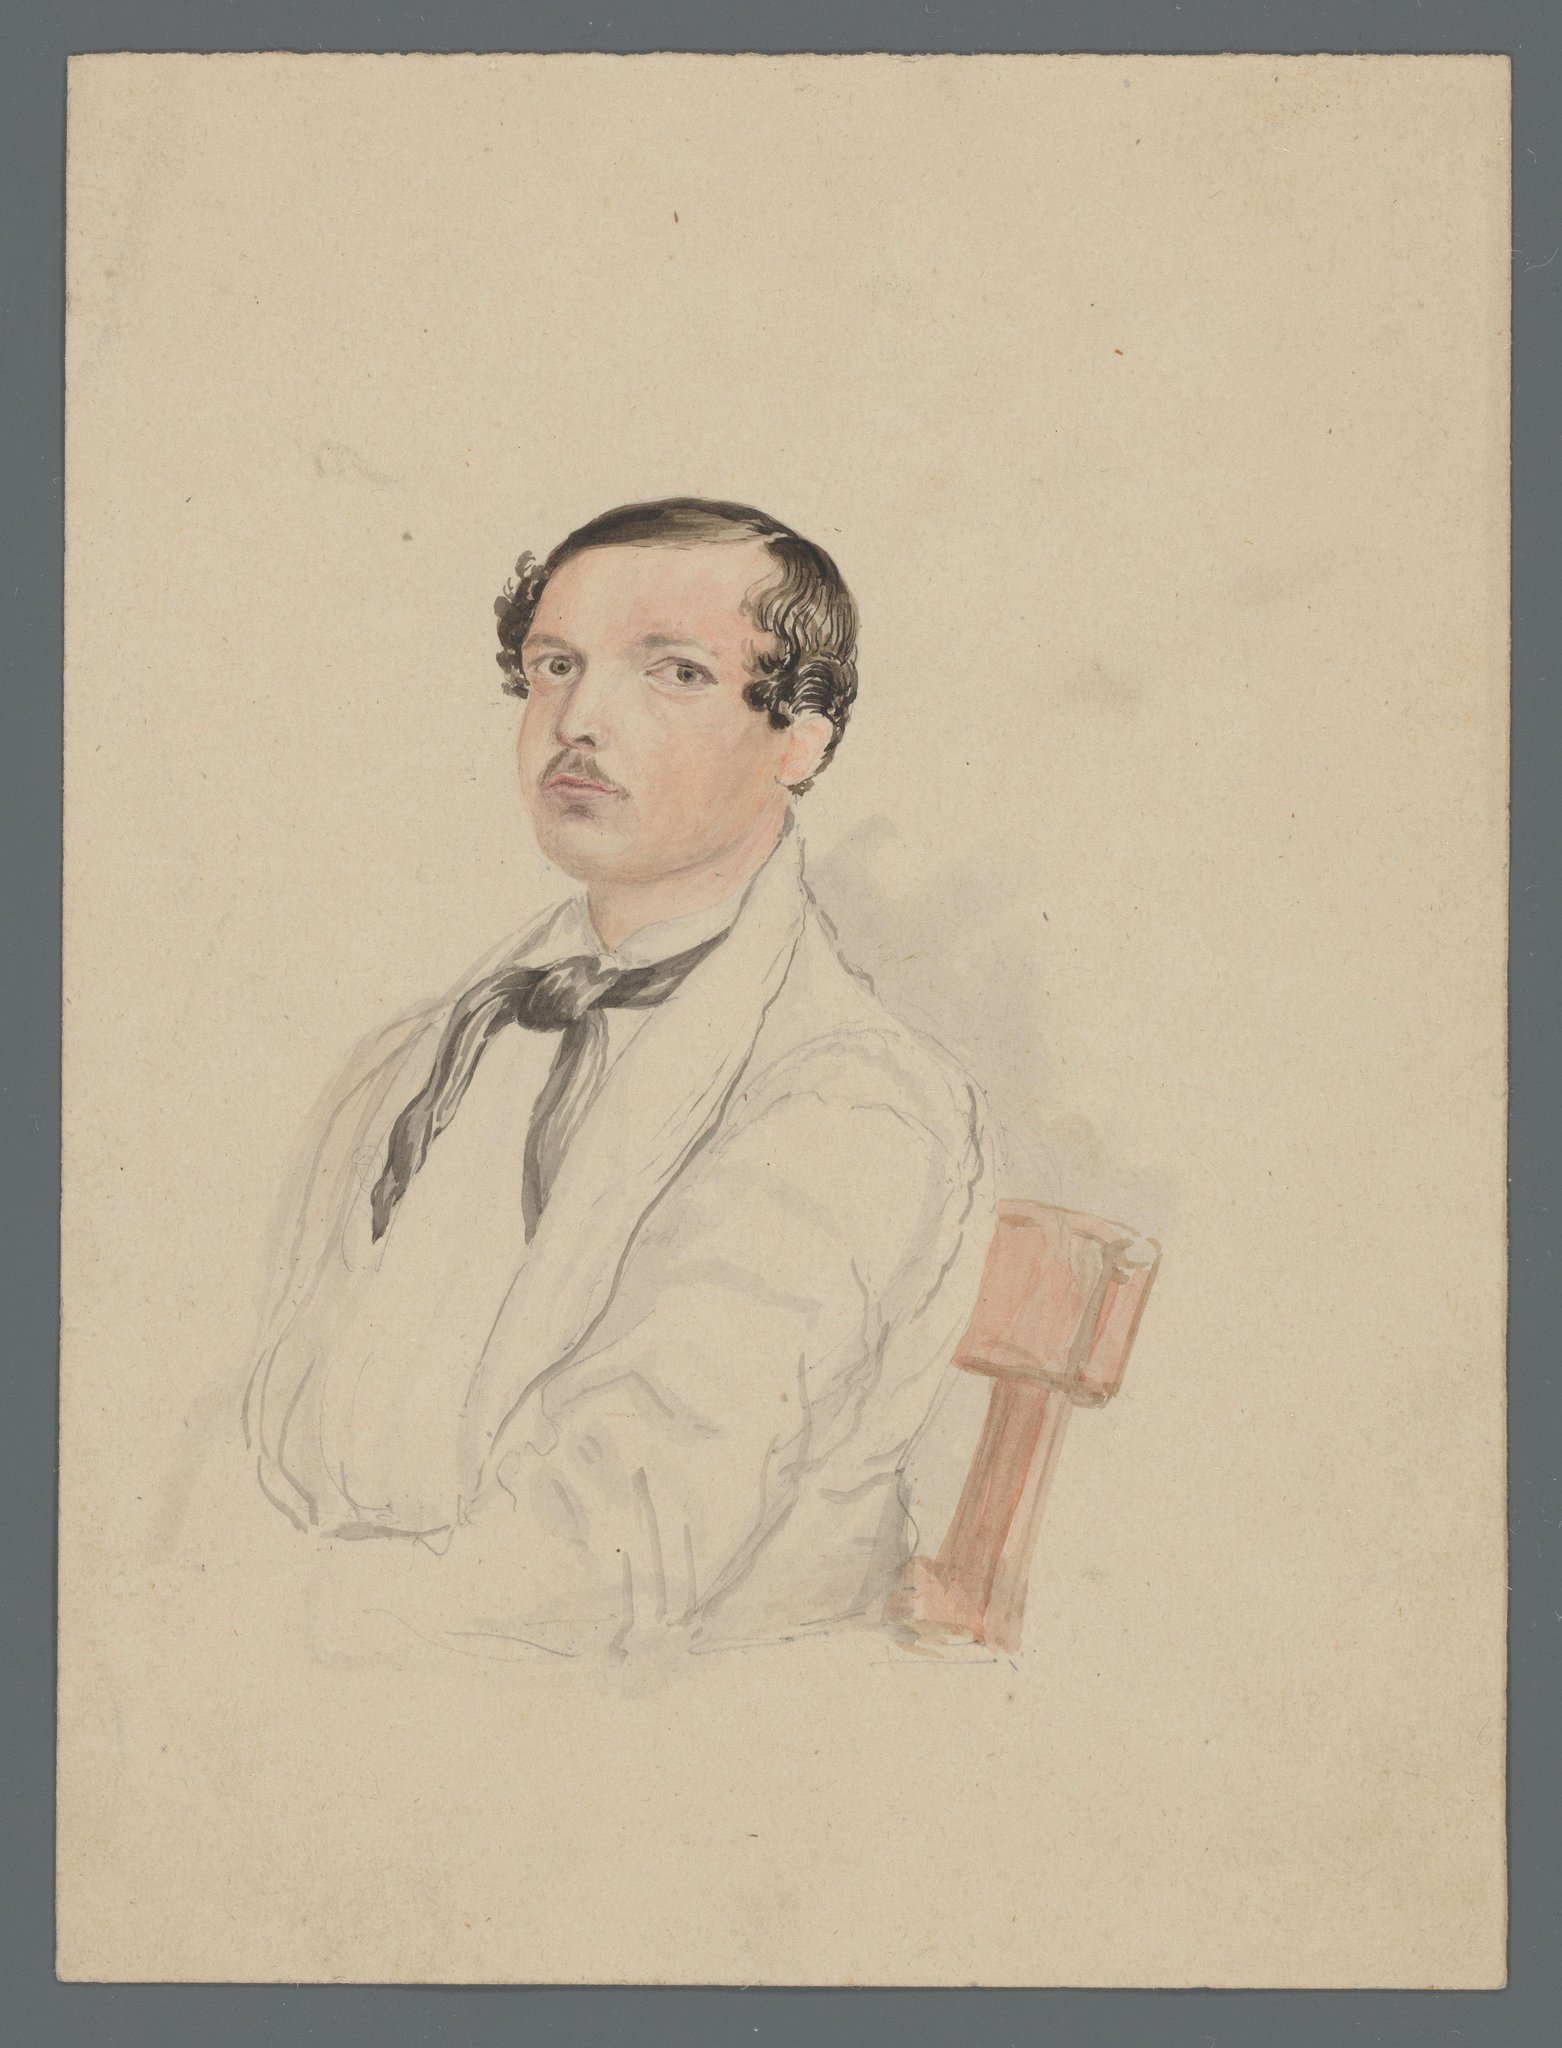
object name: drawing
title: Portret van een man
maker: frederik lambertus geerling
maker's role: naval officer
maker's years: 1815-1894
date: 1840-1880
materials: paper, pencil, watercolor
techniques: brush, pen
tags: historical persons not known by name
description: Portret van een jonge man, zittend in een stoel.